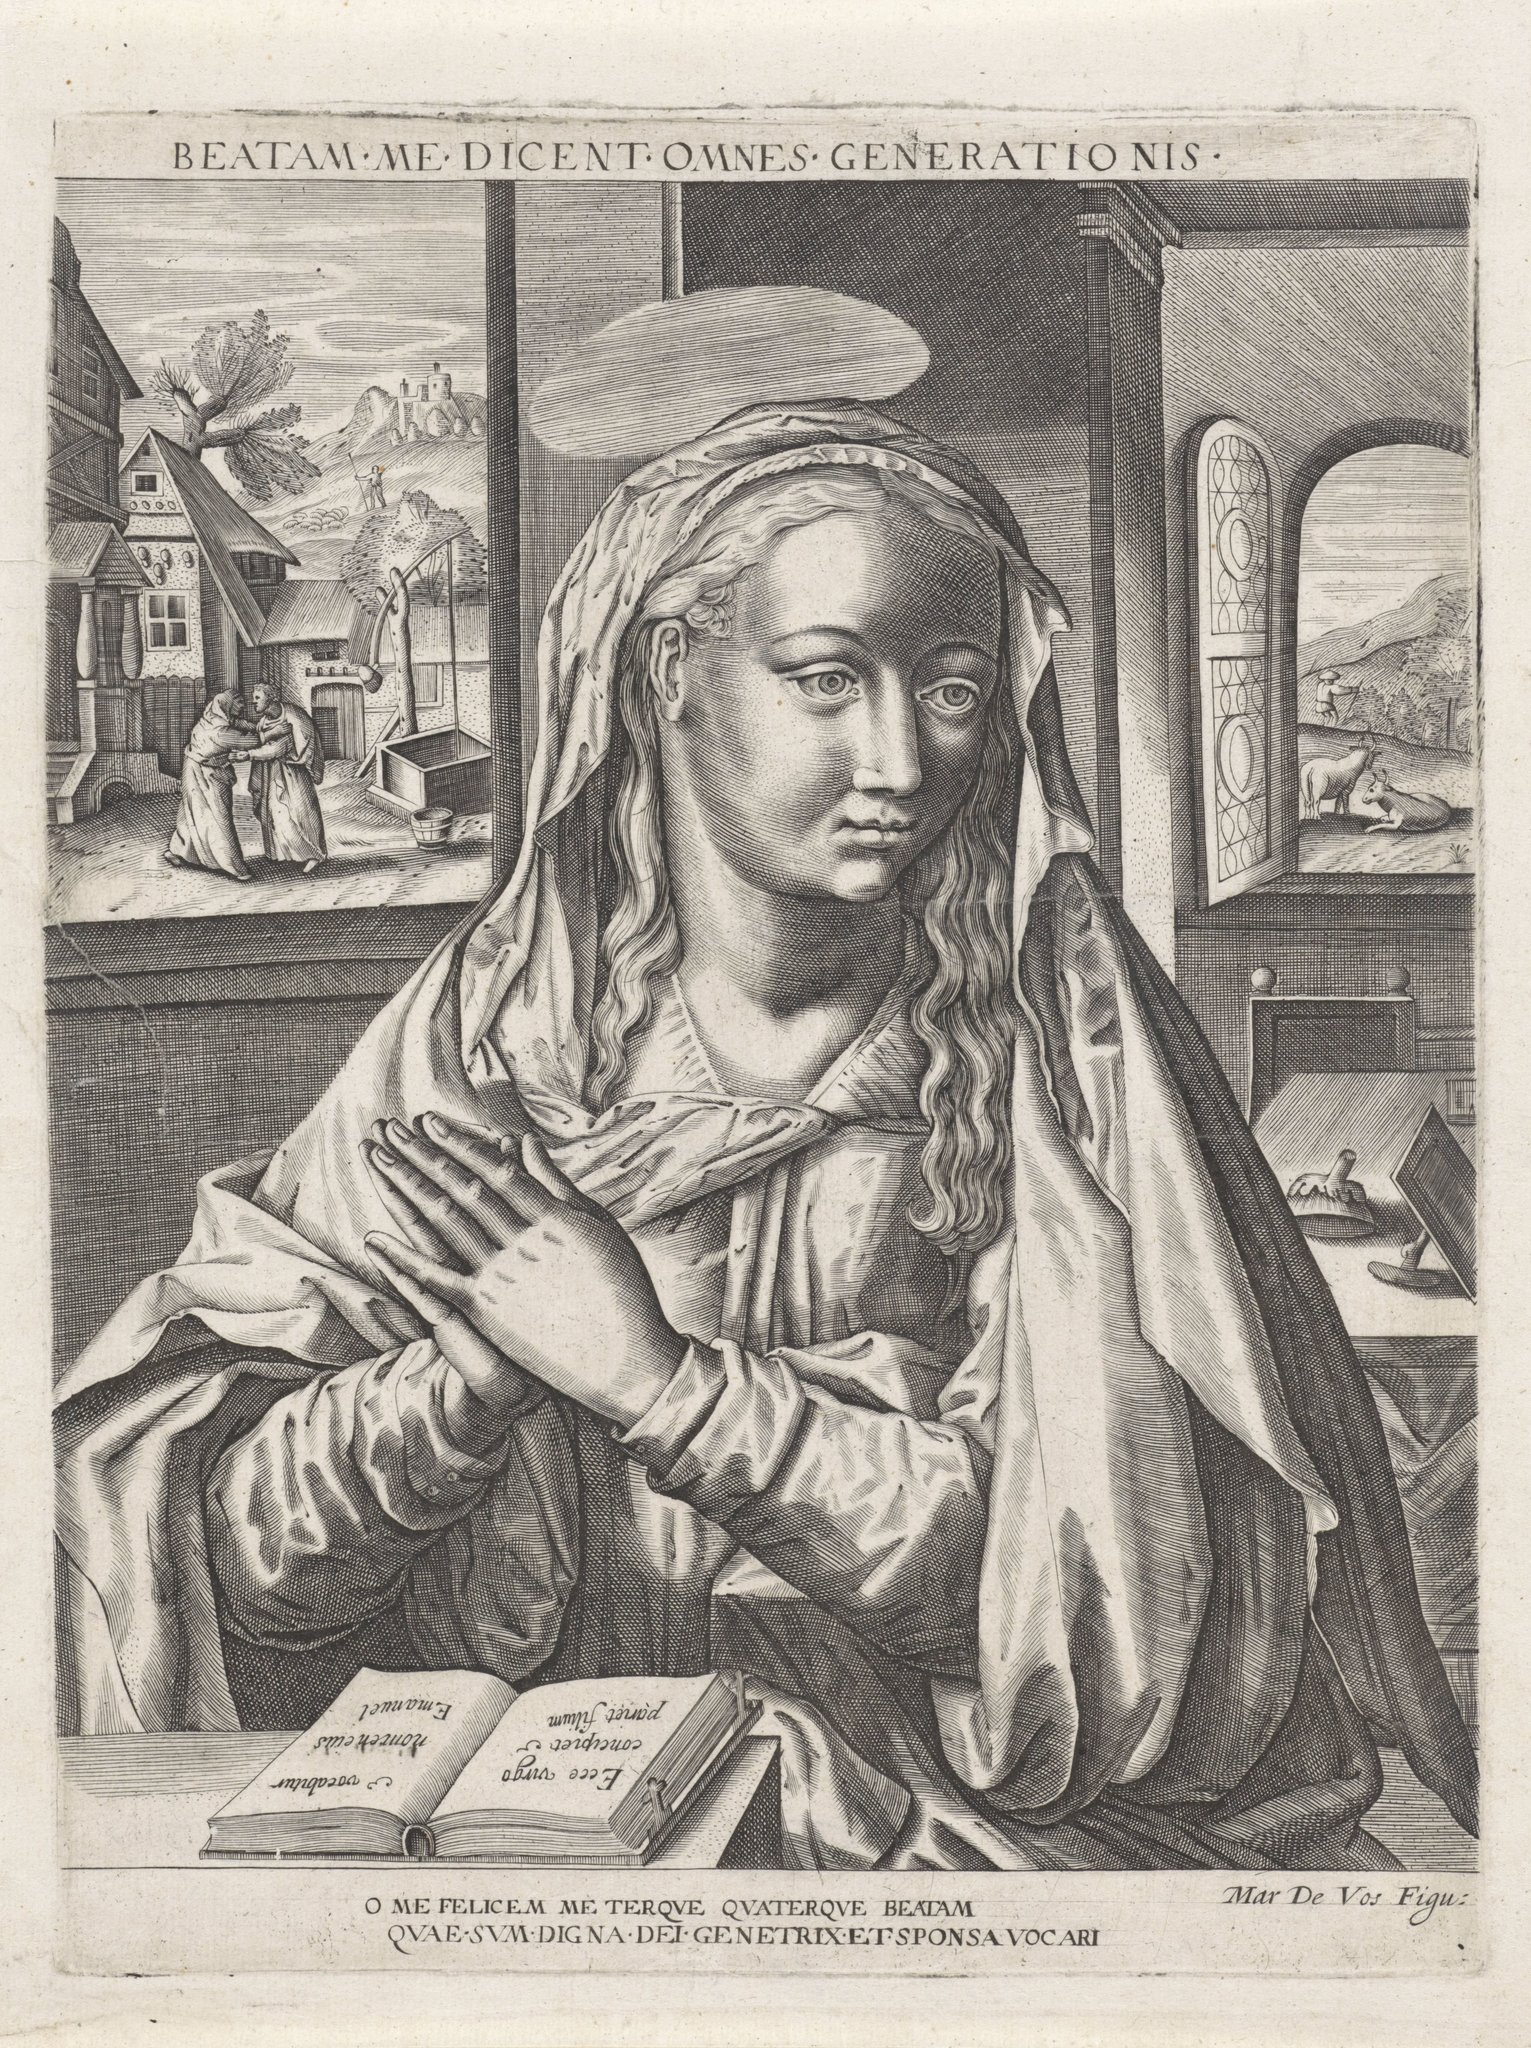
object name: print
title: Biddende Maria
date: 1558-1653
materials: paper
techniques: engraving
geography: antwerp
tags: mary praying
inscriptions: collector's mark: Lugt 2228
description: Maria bidt boven een opengeslagen boek. Achter Maria staat een tafel. Linksachter omhelzen een man en een vrouw elkaar voor een gebouw. Rechtsachter een herder bij een kudde koeien. Boven een éénregelige tekst in het Latijn en onder een tweeregelige tekst in het Latijn.